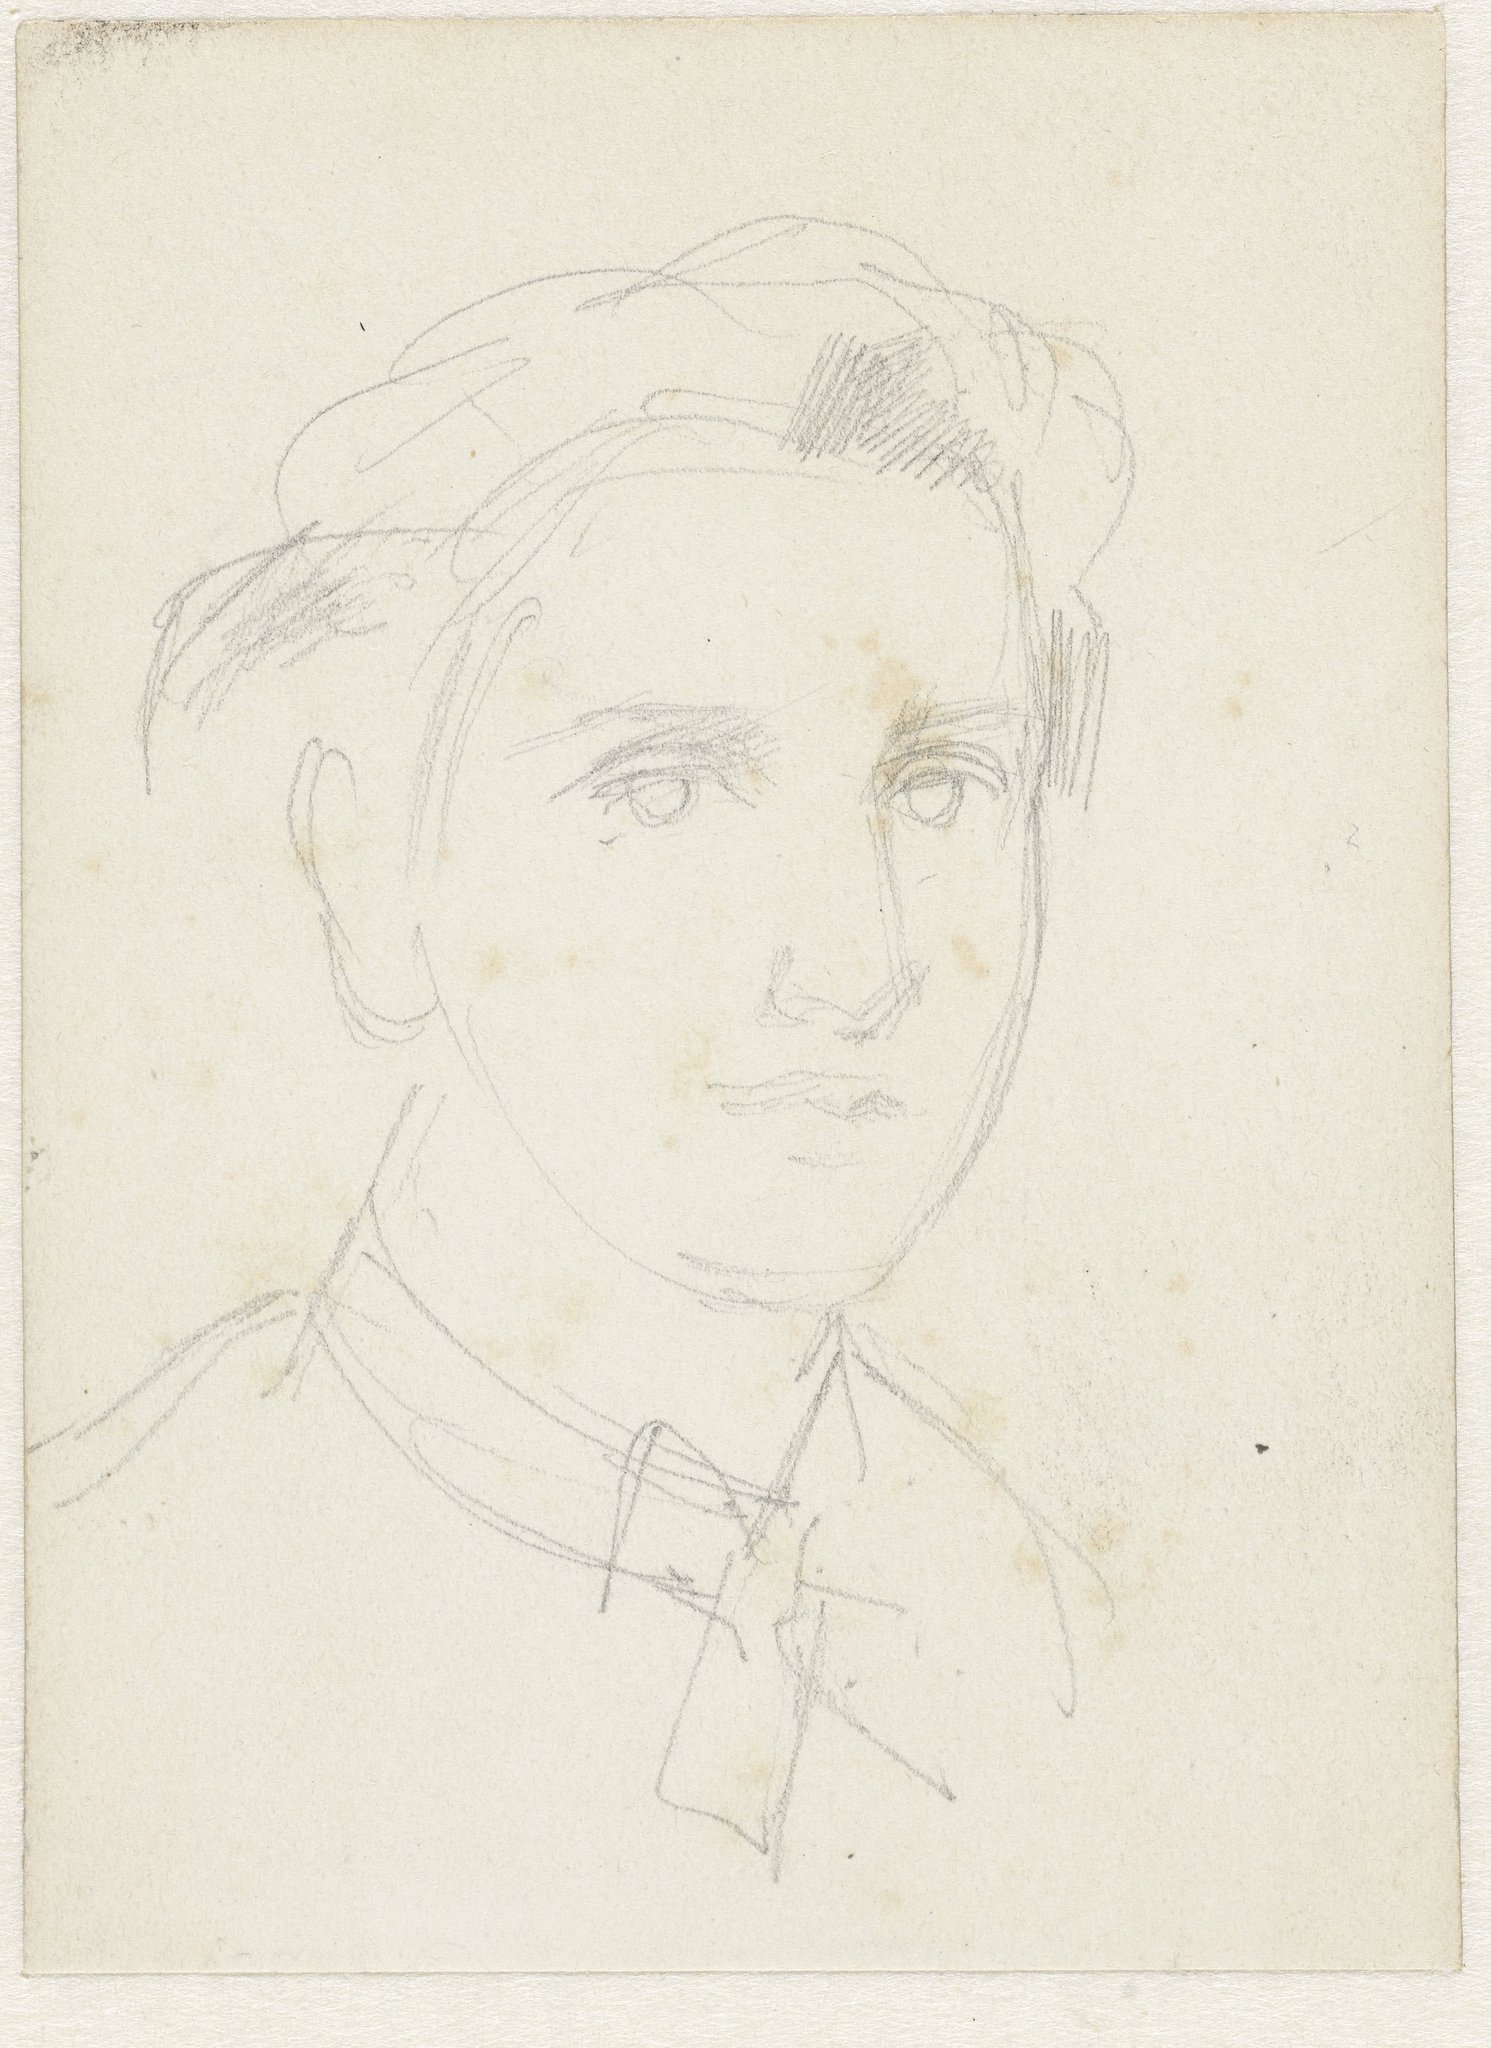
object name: drawing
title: Vrouwenhoofd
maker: august allebé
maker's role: draughtsman, print maker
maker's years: 1838-1927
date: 1848-1927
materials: paper, pencil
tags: anonymous historical person portrayed alone